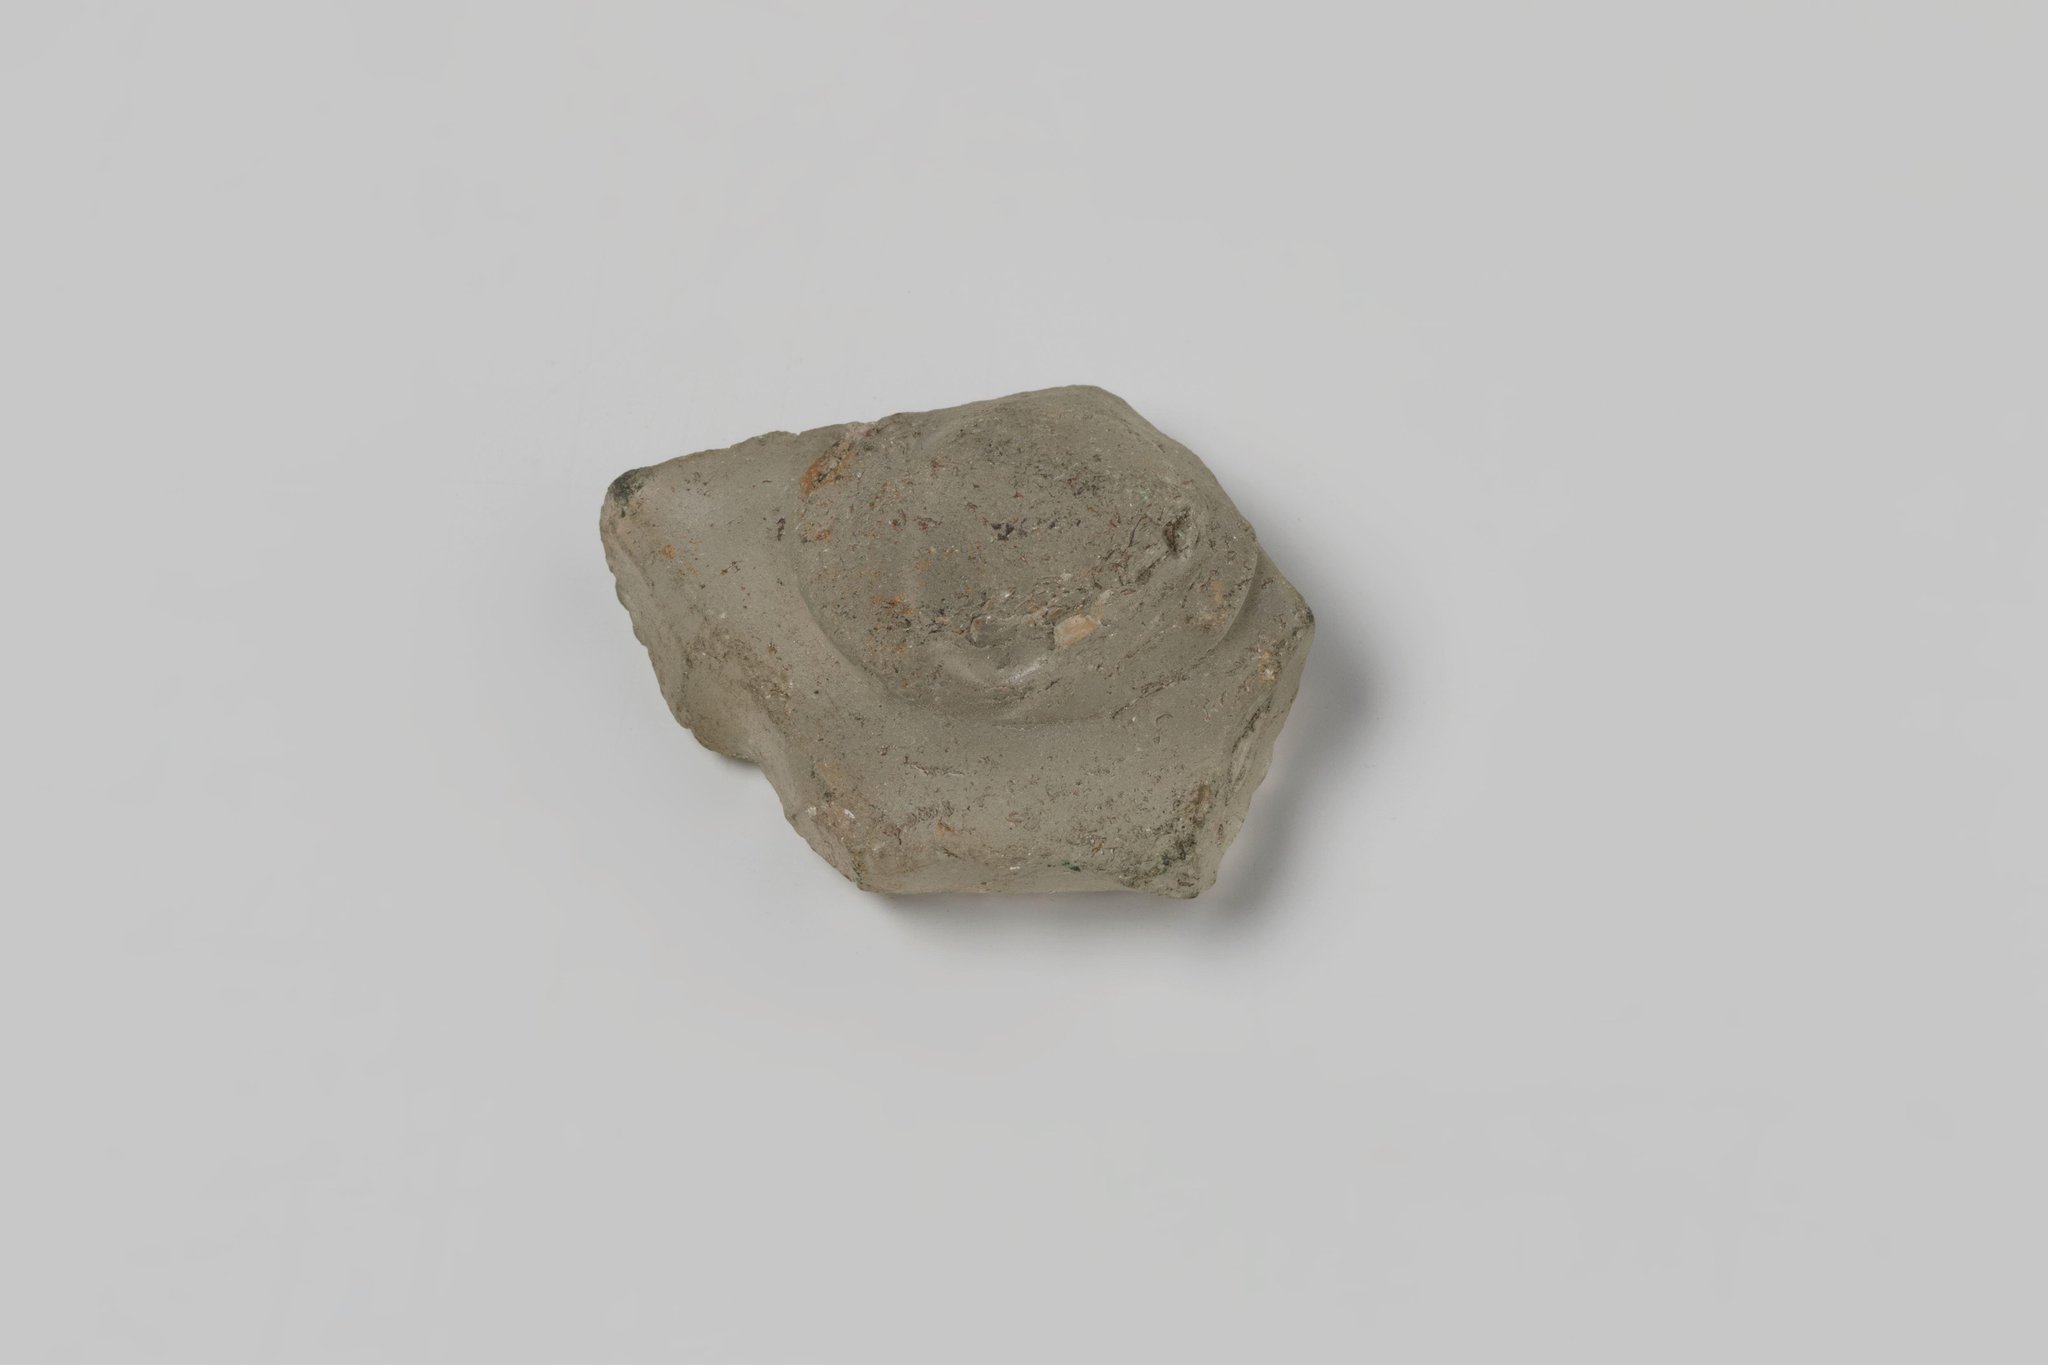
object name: scheepswrakvondst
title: Fragment glas uit het wrak van de Oost-Indiëvaarder Hollandia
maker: Anonymous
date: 1700-1743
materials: glass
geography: netherlands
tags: verenigde oostindische compagnie, hollandia (schip), annet